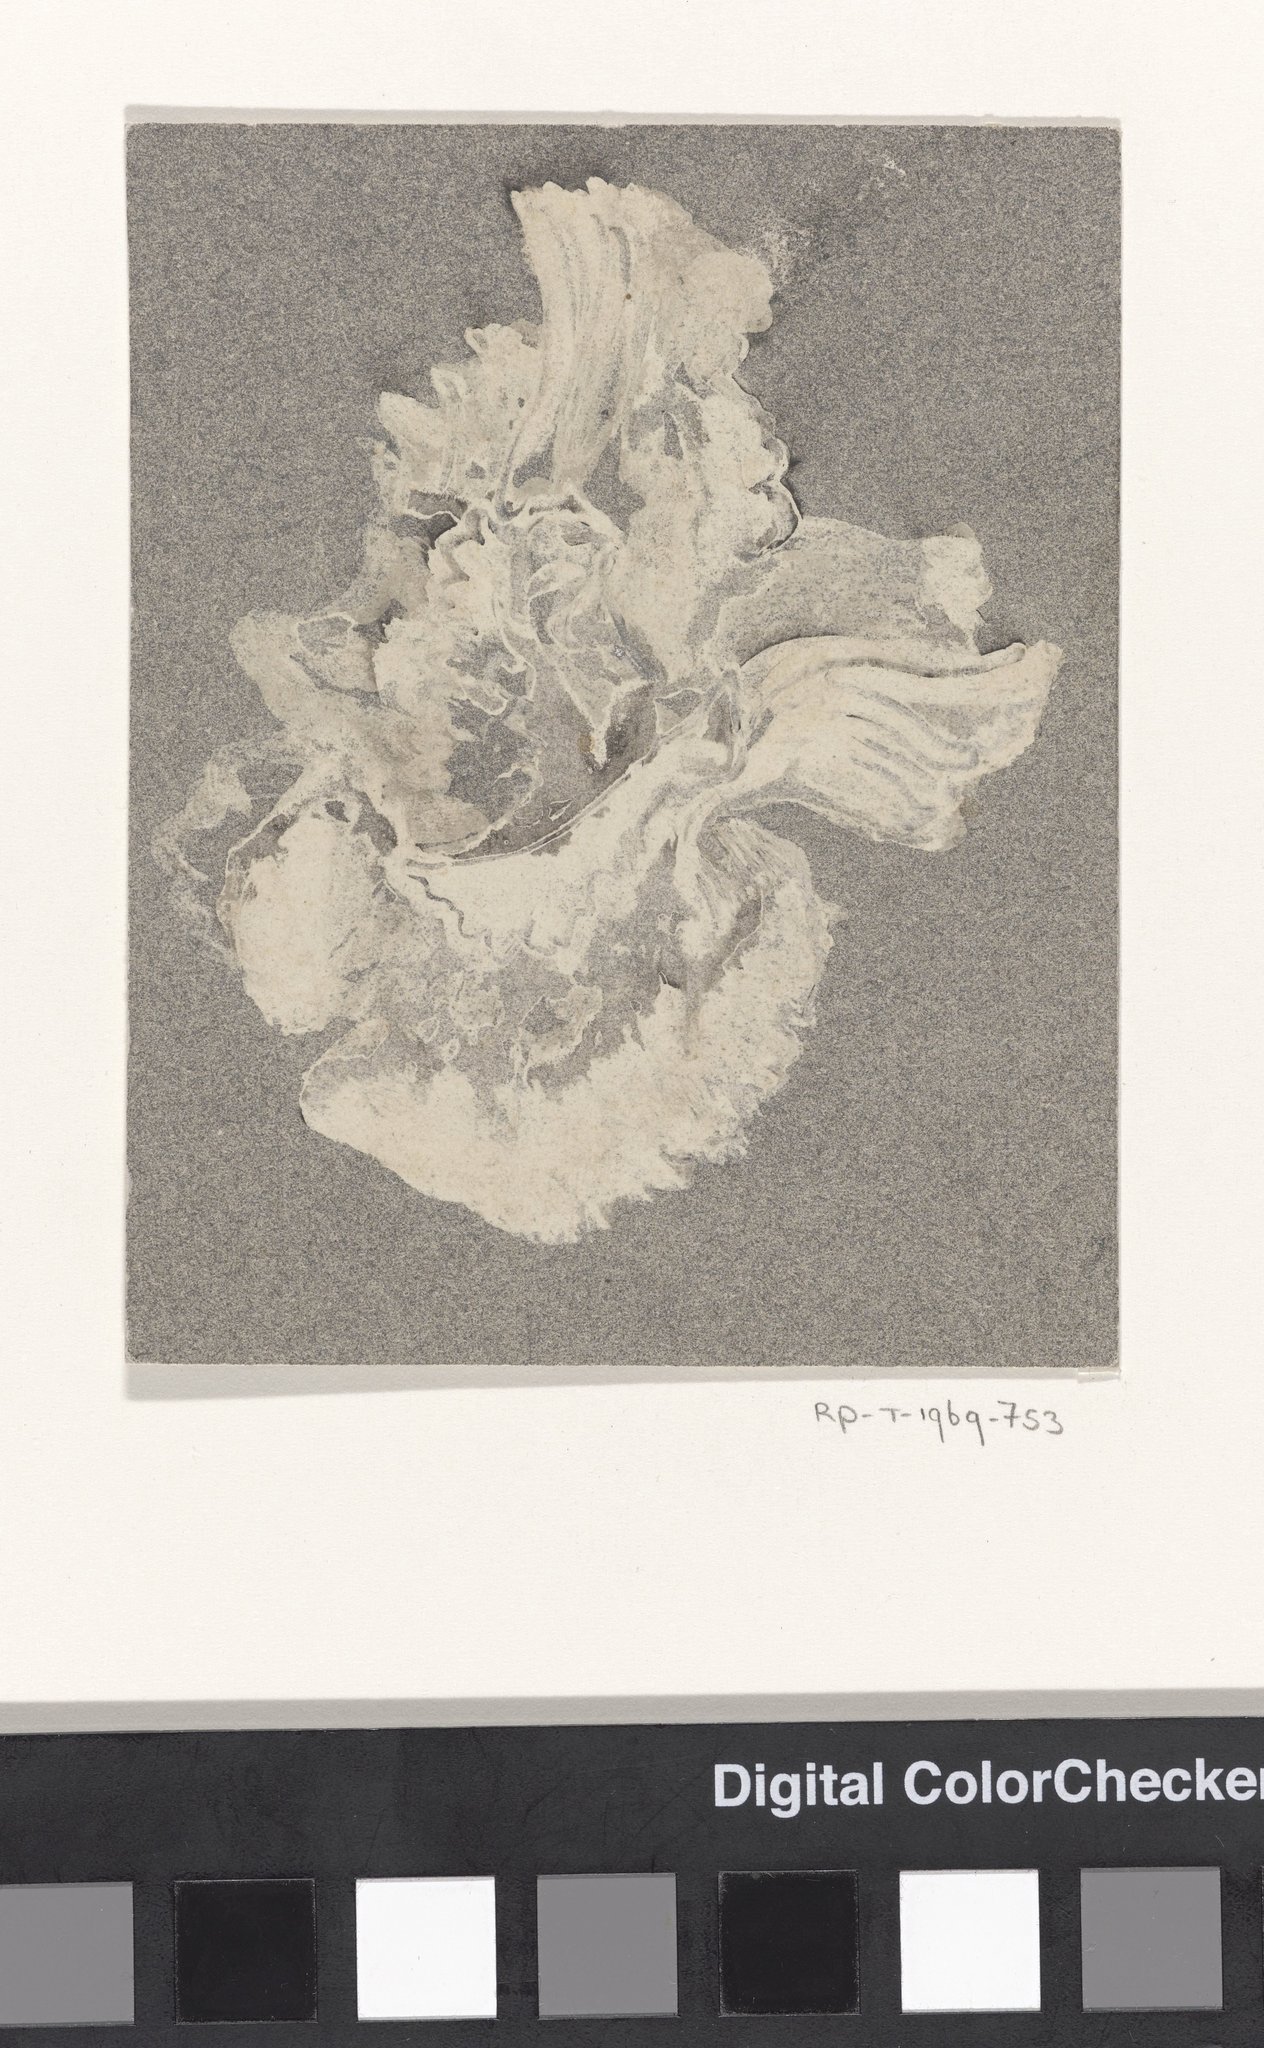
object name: drawing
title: Azaleabloem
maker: carel adolph lion cachet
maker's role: draughtsman, print maker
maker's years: 1864-1945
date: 1915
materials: cardboard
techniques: brush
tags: flowers